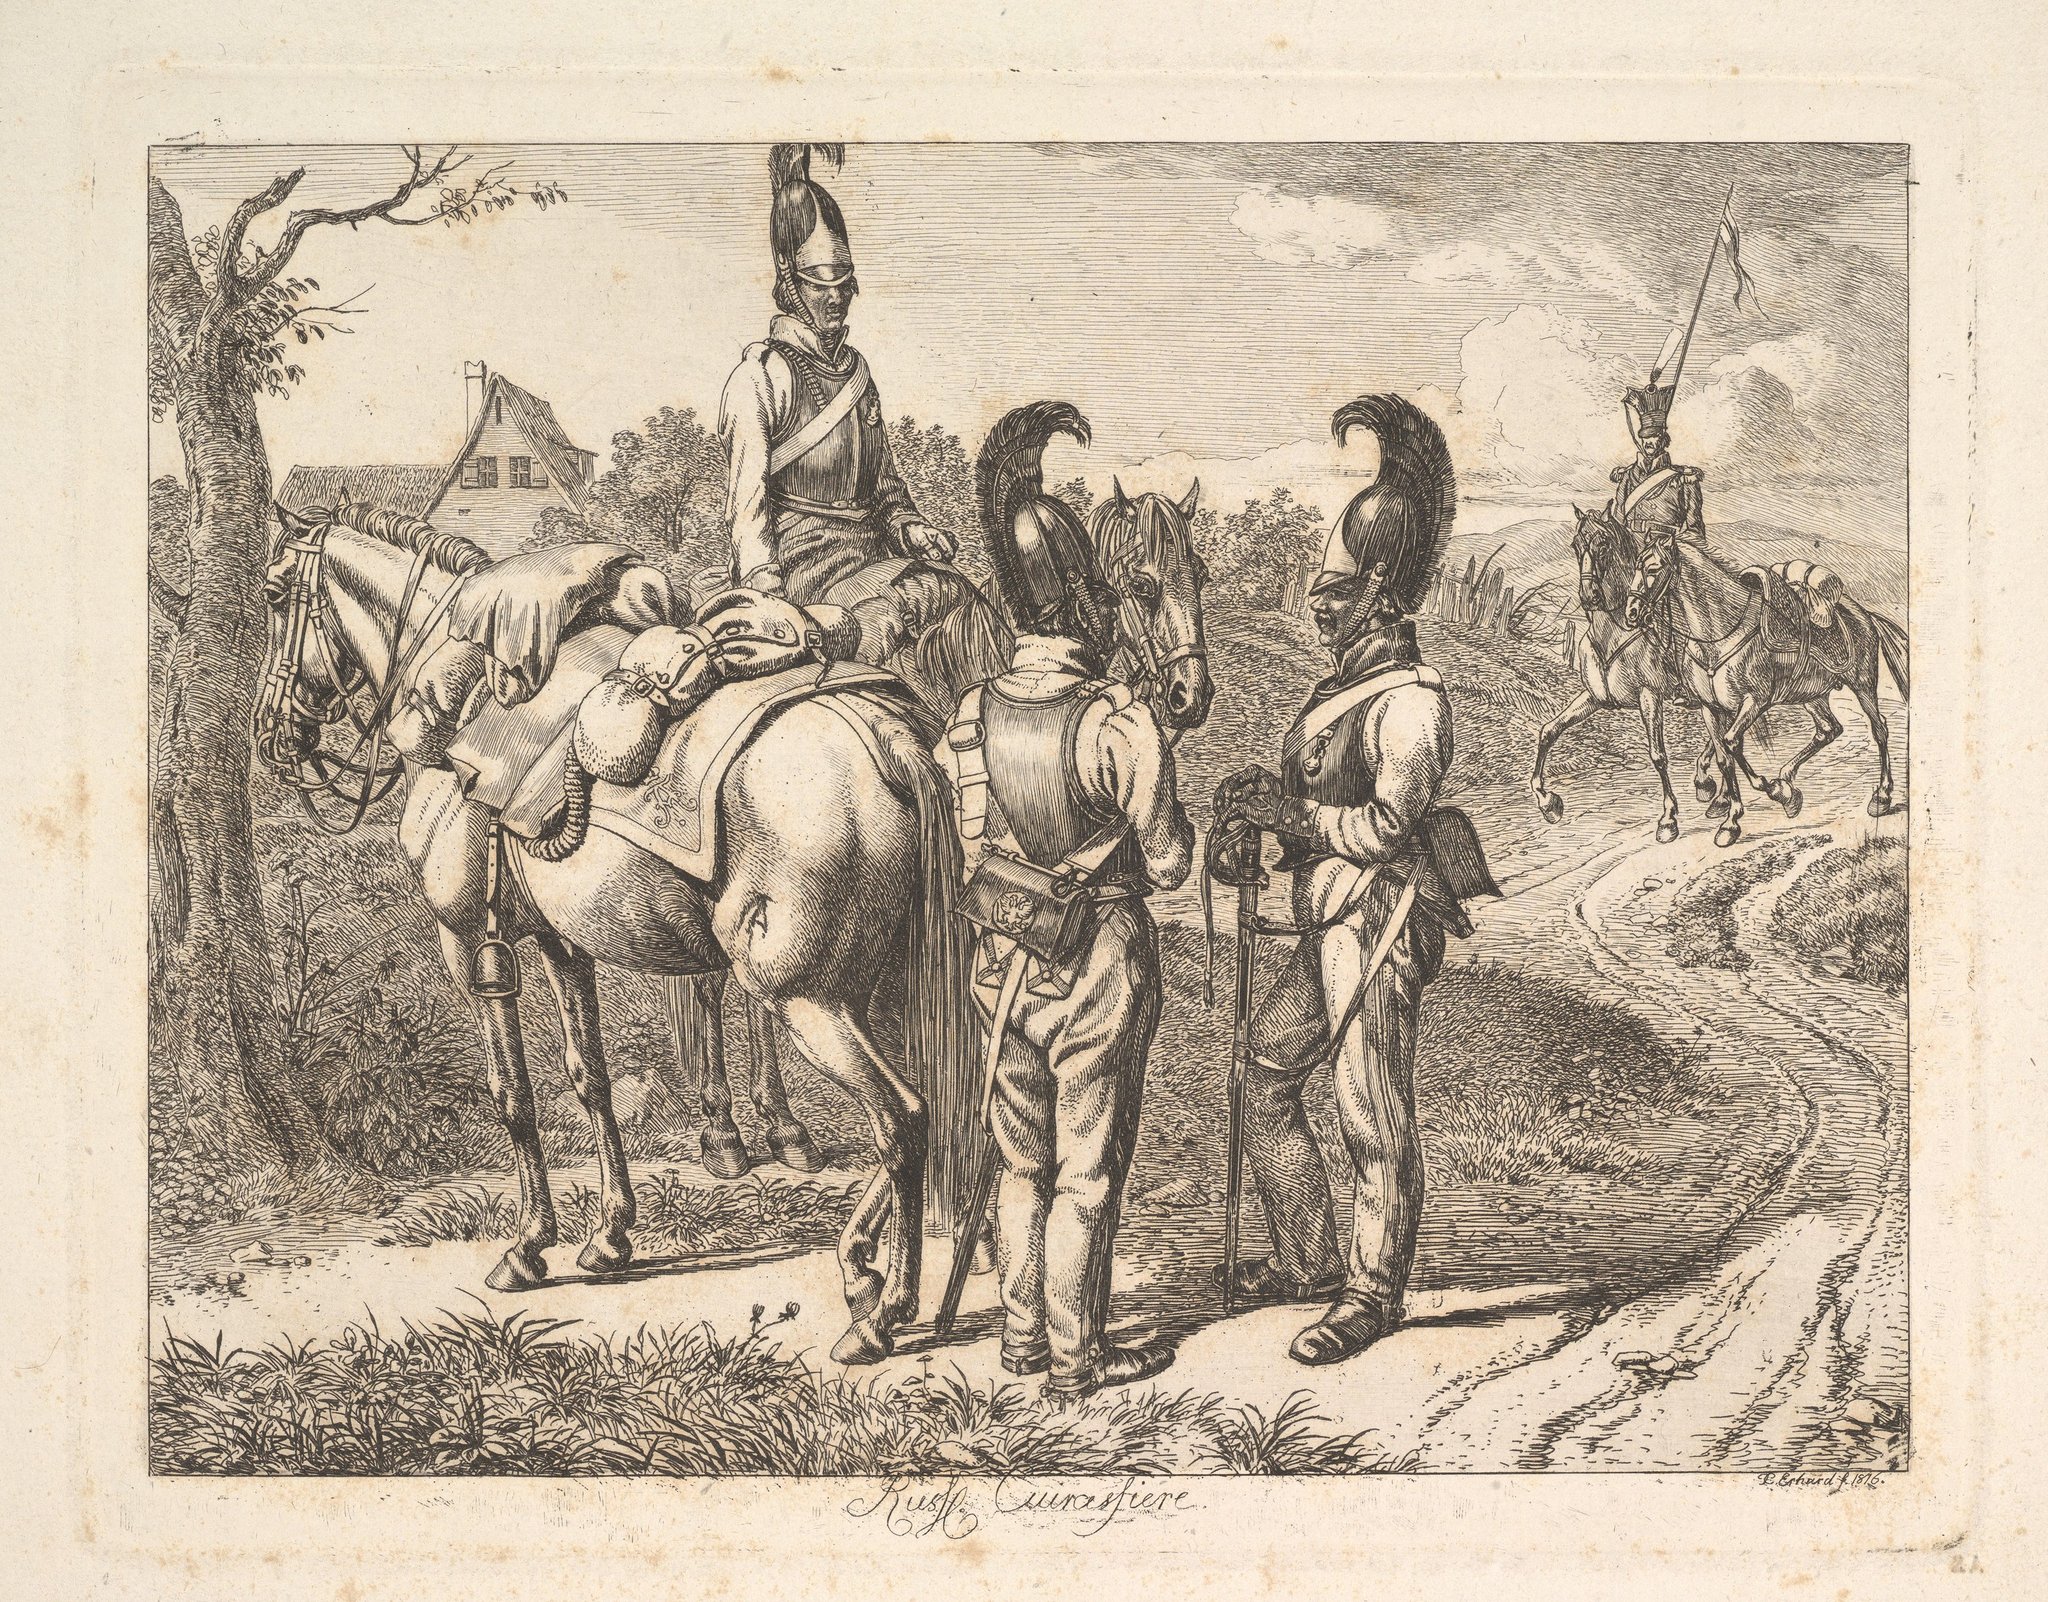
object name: print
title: Russian Cuirassiers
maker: johann christoph erhard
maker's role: artist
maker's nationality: german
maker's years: 1795-1822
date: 1816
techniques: etching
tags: soldiers,weapons,men,horses